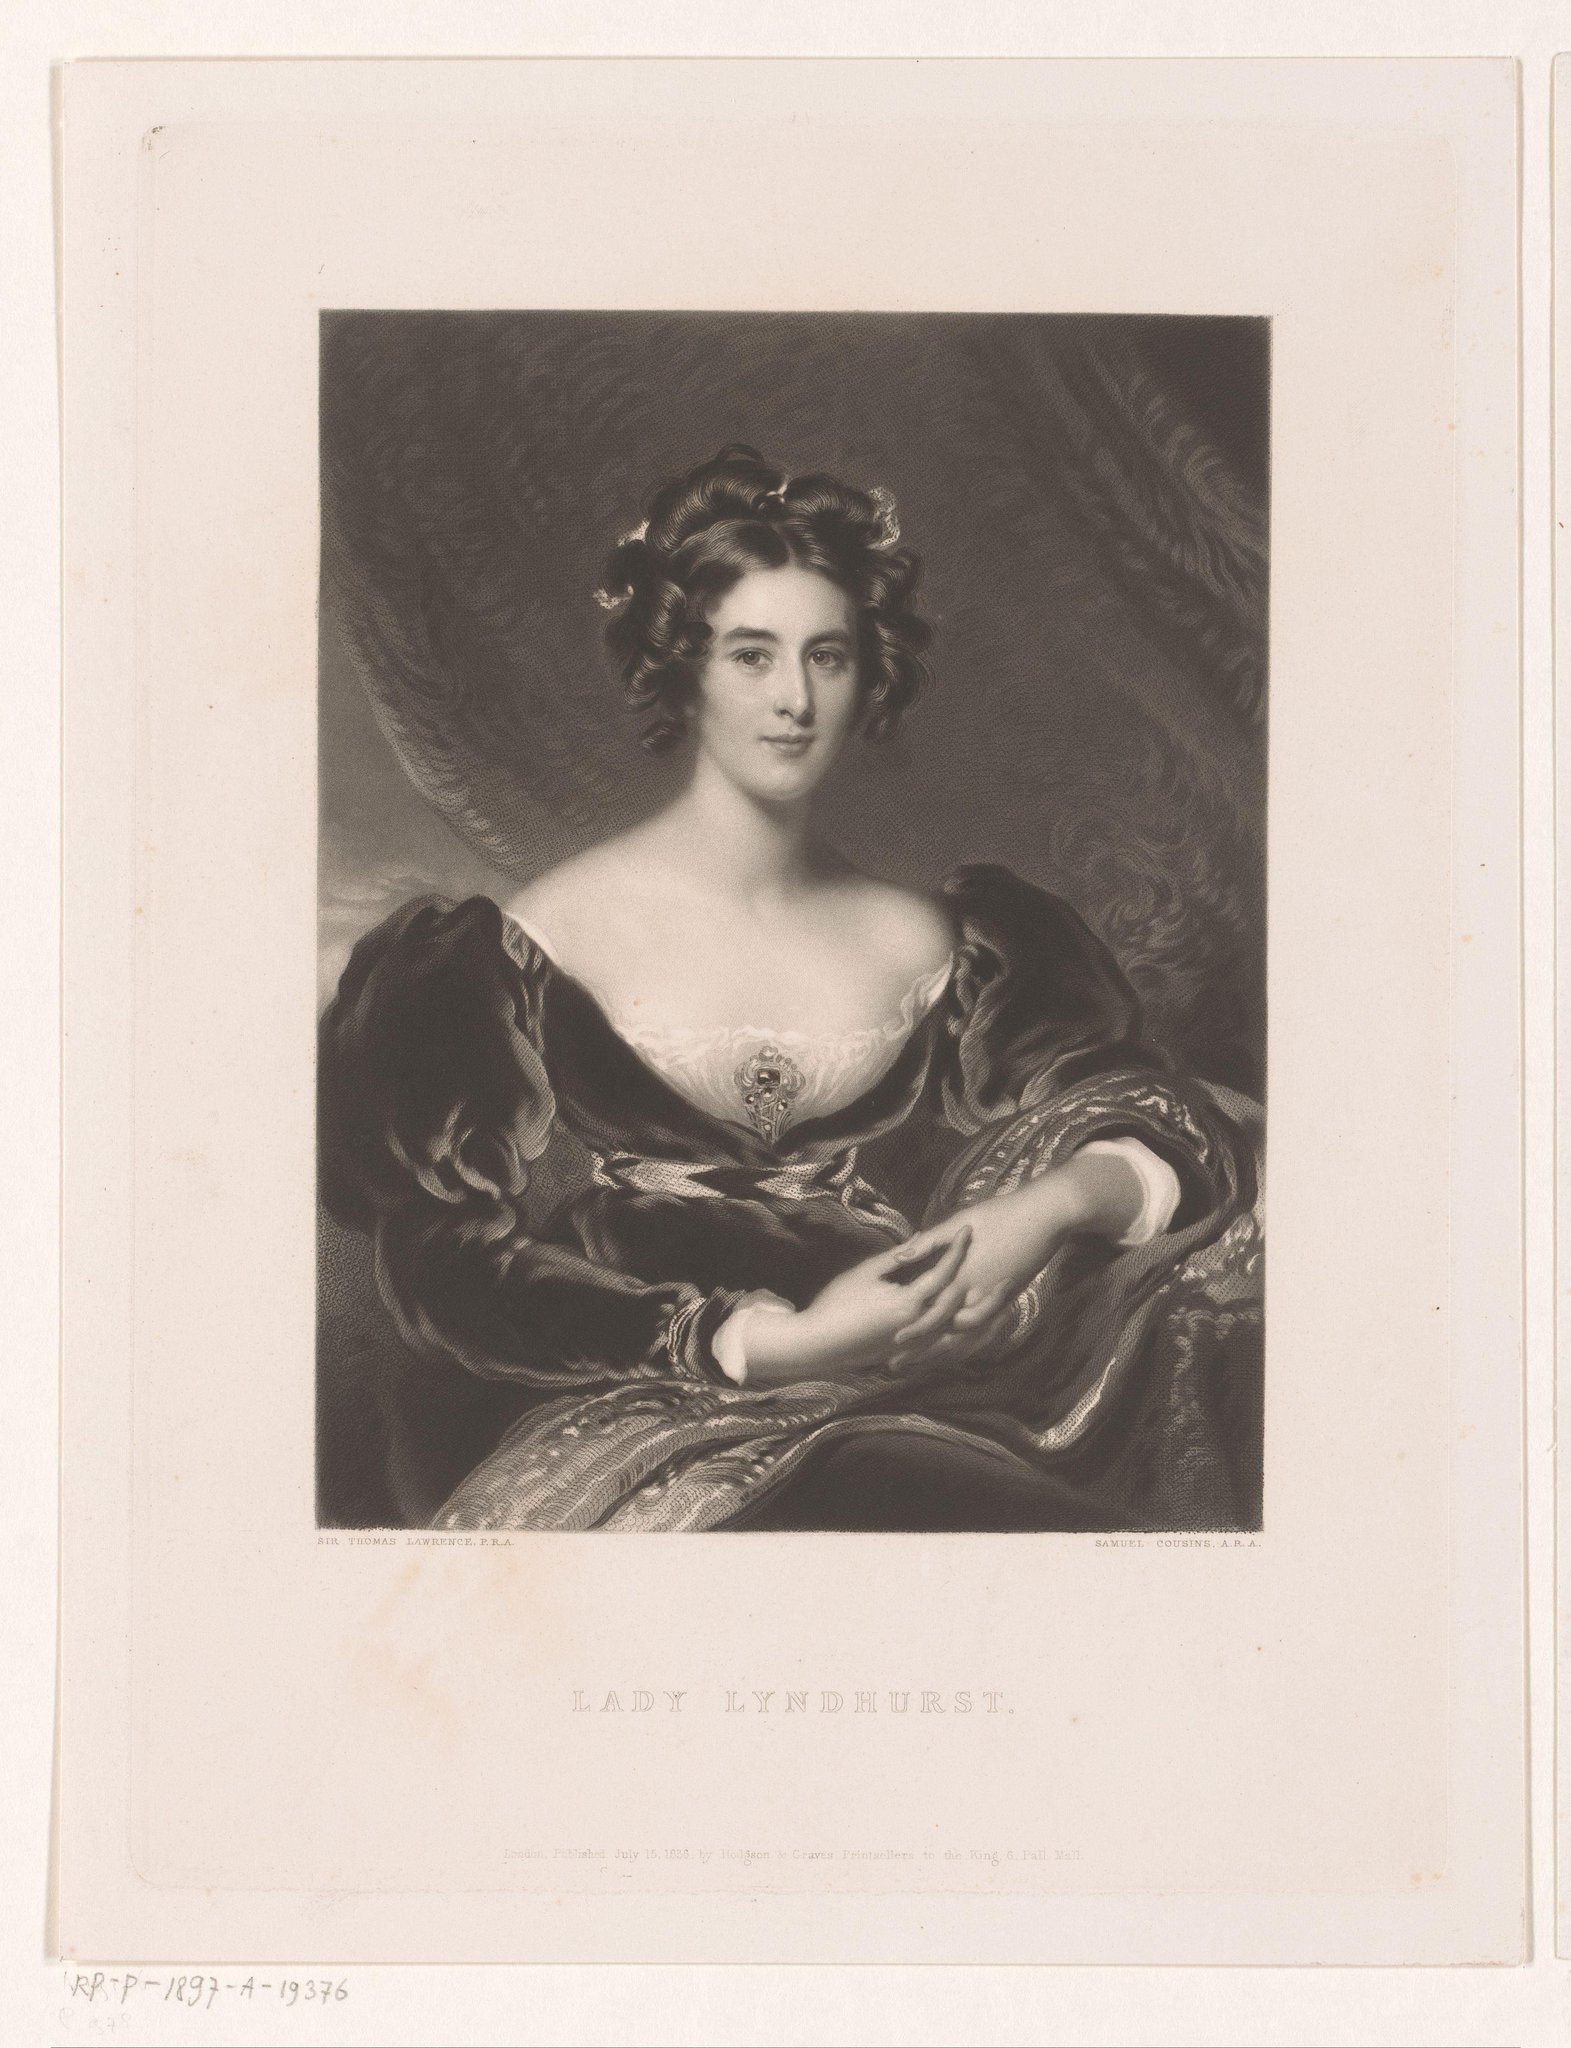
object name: print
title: Portret van Sarah Garay Lyndhurst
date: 1836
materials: paper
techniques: etching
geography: london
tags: historical persons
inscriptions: collector's mark: Lugt 2228